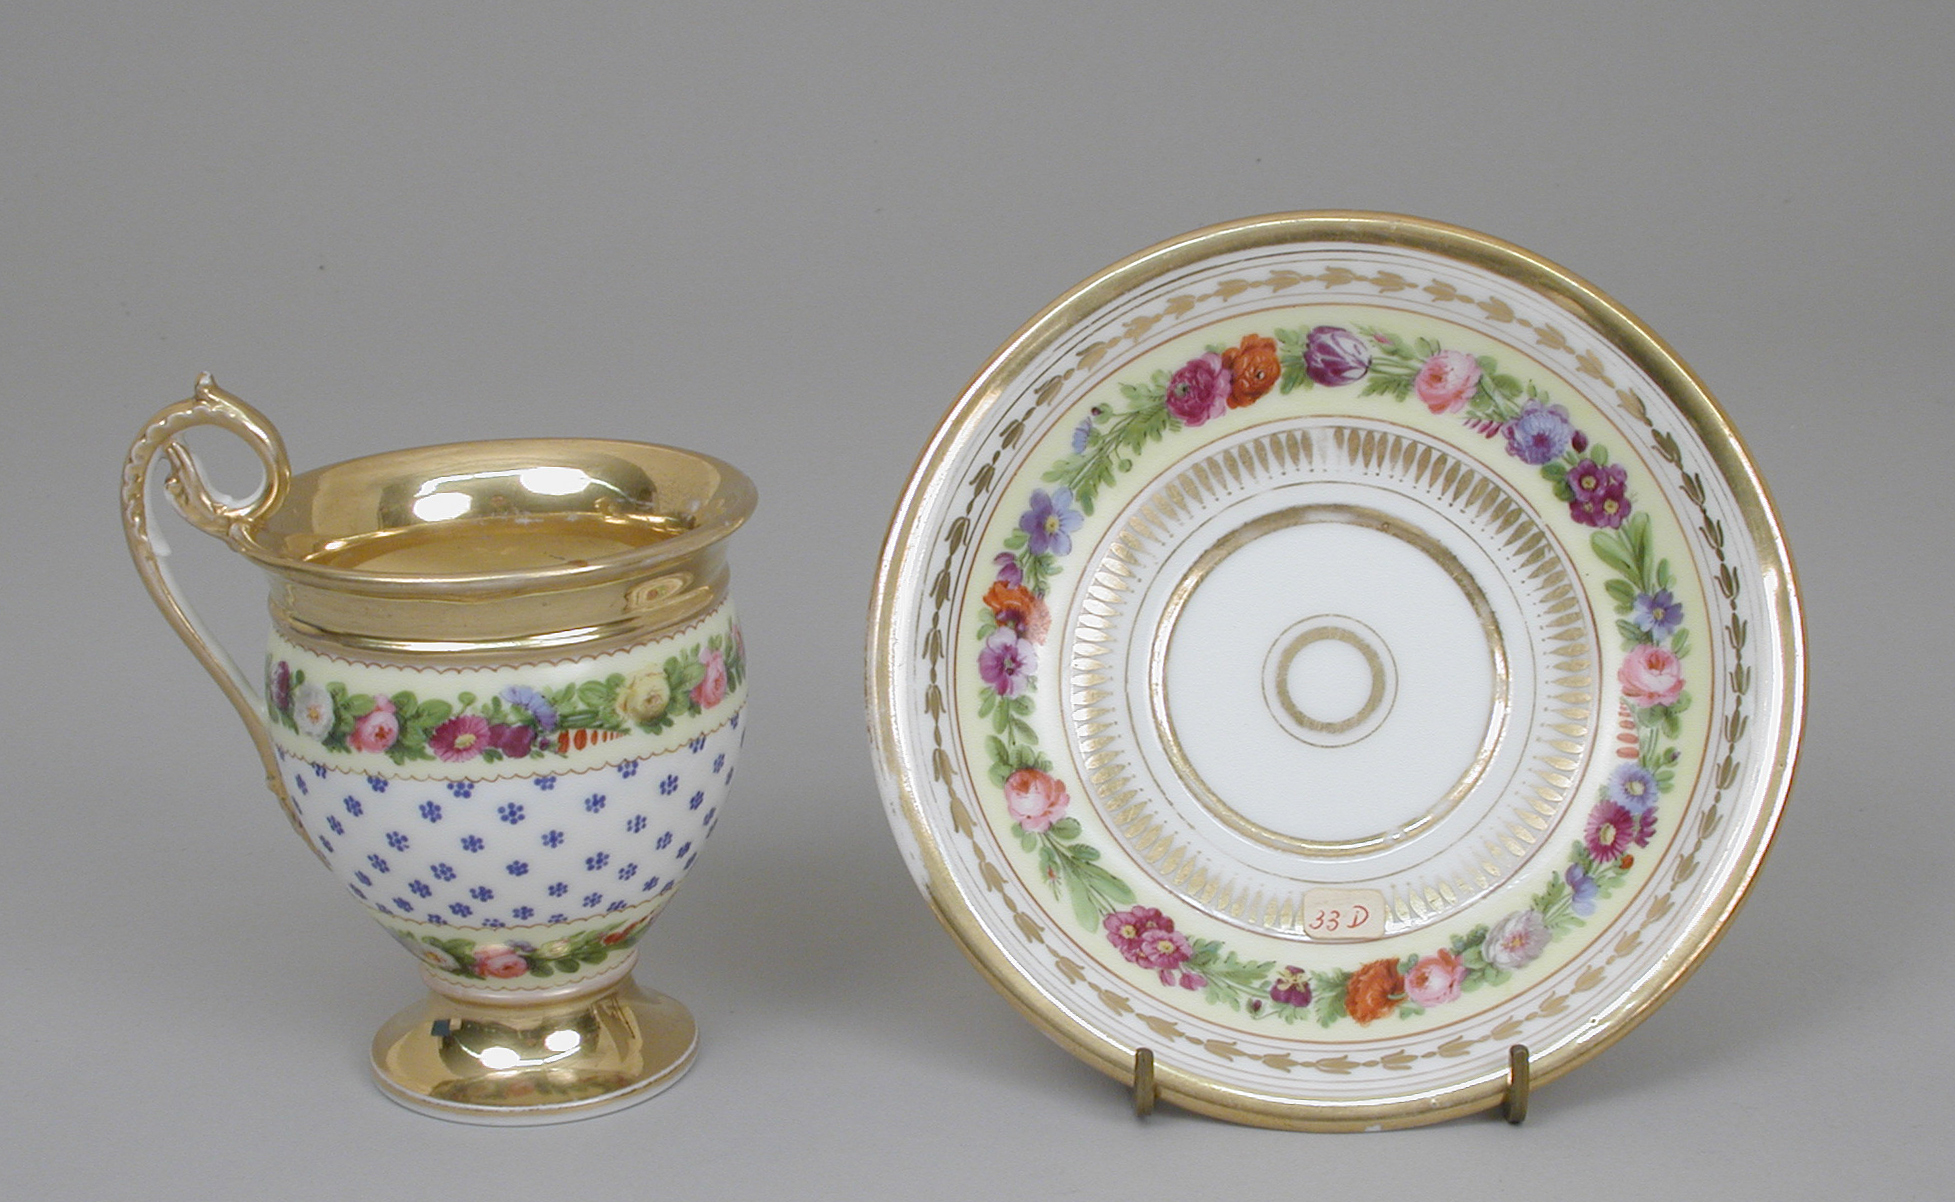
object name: cup and saucer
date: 1810-1830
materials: hard paste porcelain